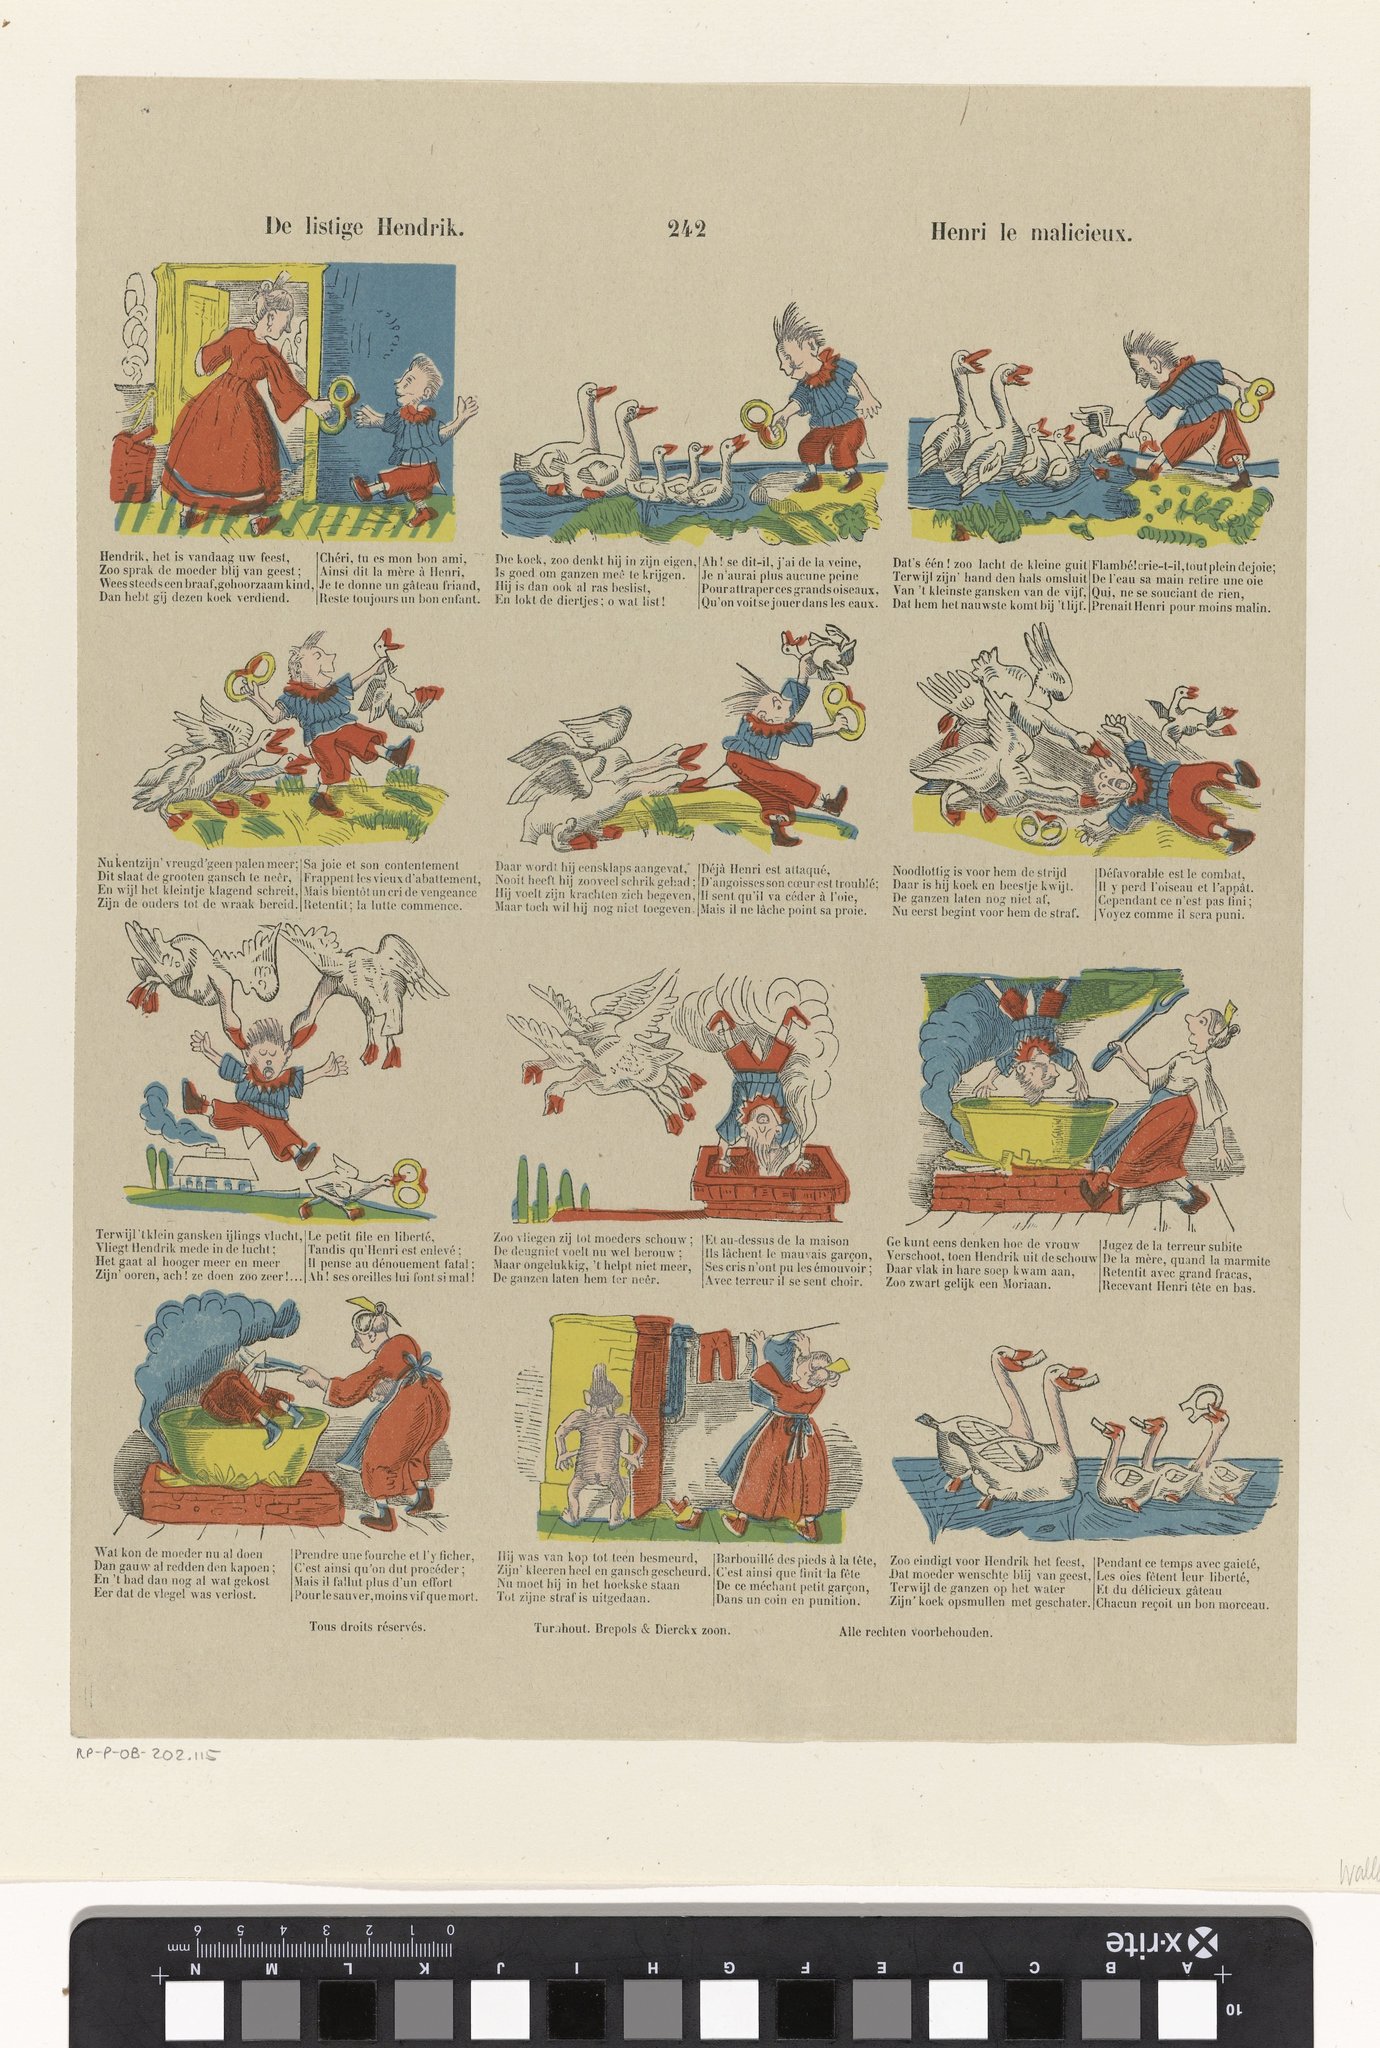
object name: popular print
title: De listige Hendrik / Henri le malicieux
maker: Anonymous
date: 1833-1911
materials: paper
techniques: lithograph, letterpress printing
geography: turnhout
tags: correction of naughty children, water-birds: goose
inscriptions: collector's mark: Lugt 2760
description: Blad met 12 voorstellingen over Hendrik die de ganzen plaagt. De ganzen nemen hem als wraak mee op een luchtreis, waarna hij bij zijn moeder in een ketel met rijstebrij belandt. Onder elke afbeelding een onderschrift in het Nederlands en in het Frans in twee kolommen. Genummerd midden boven: 242.